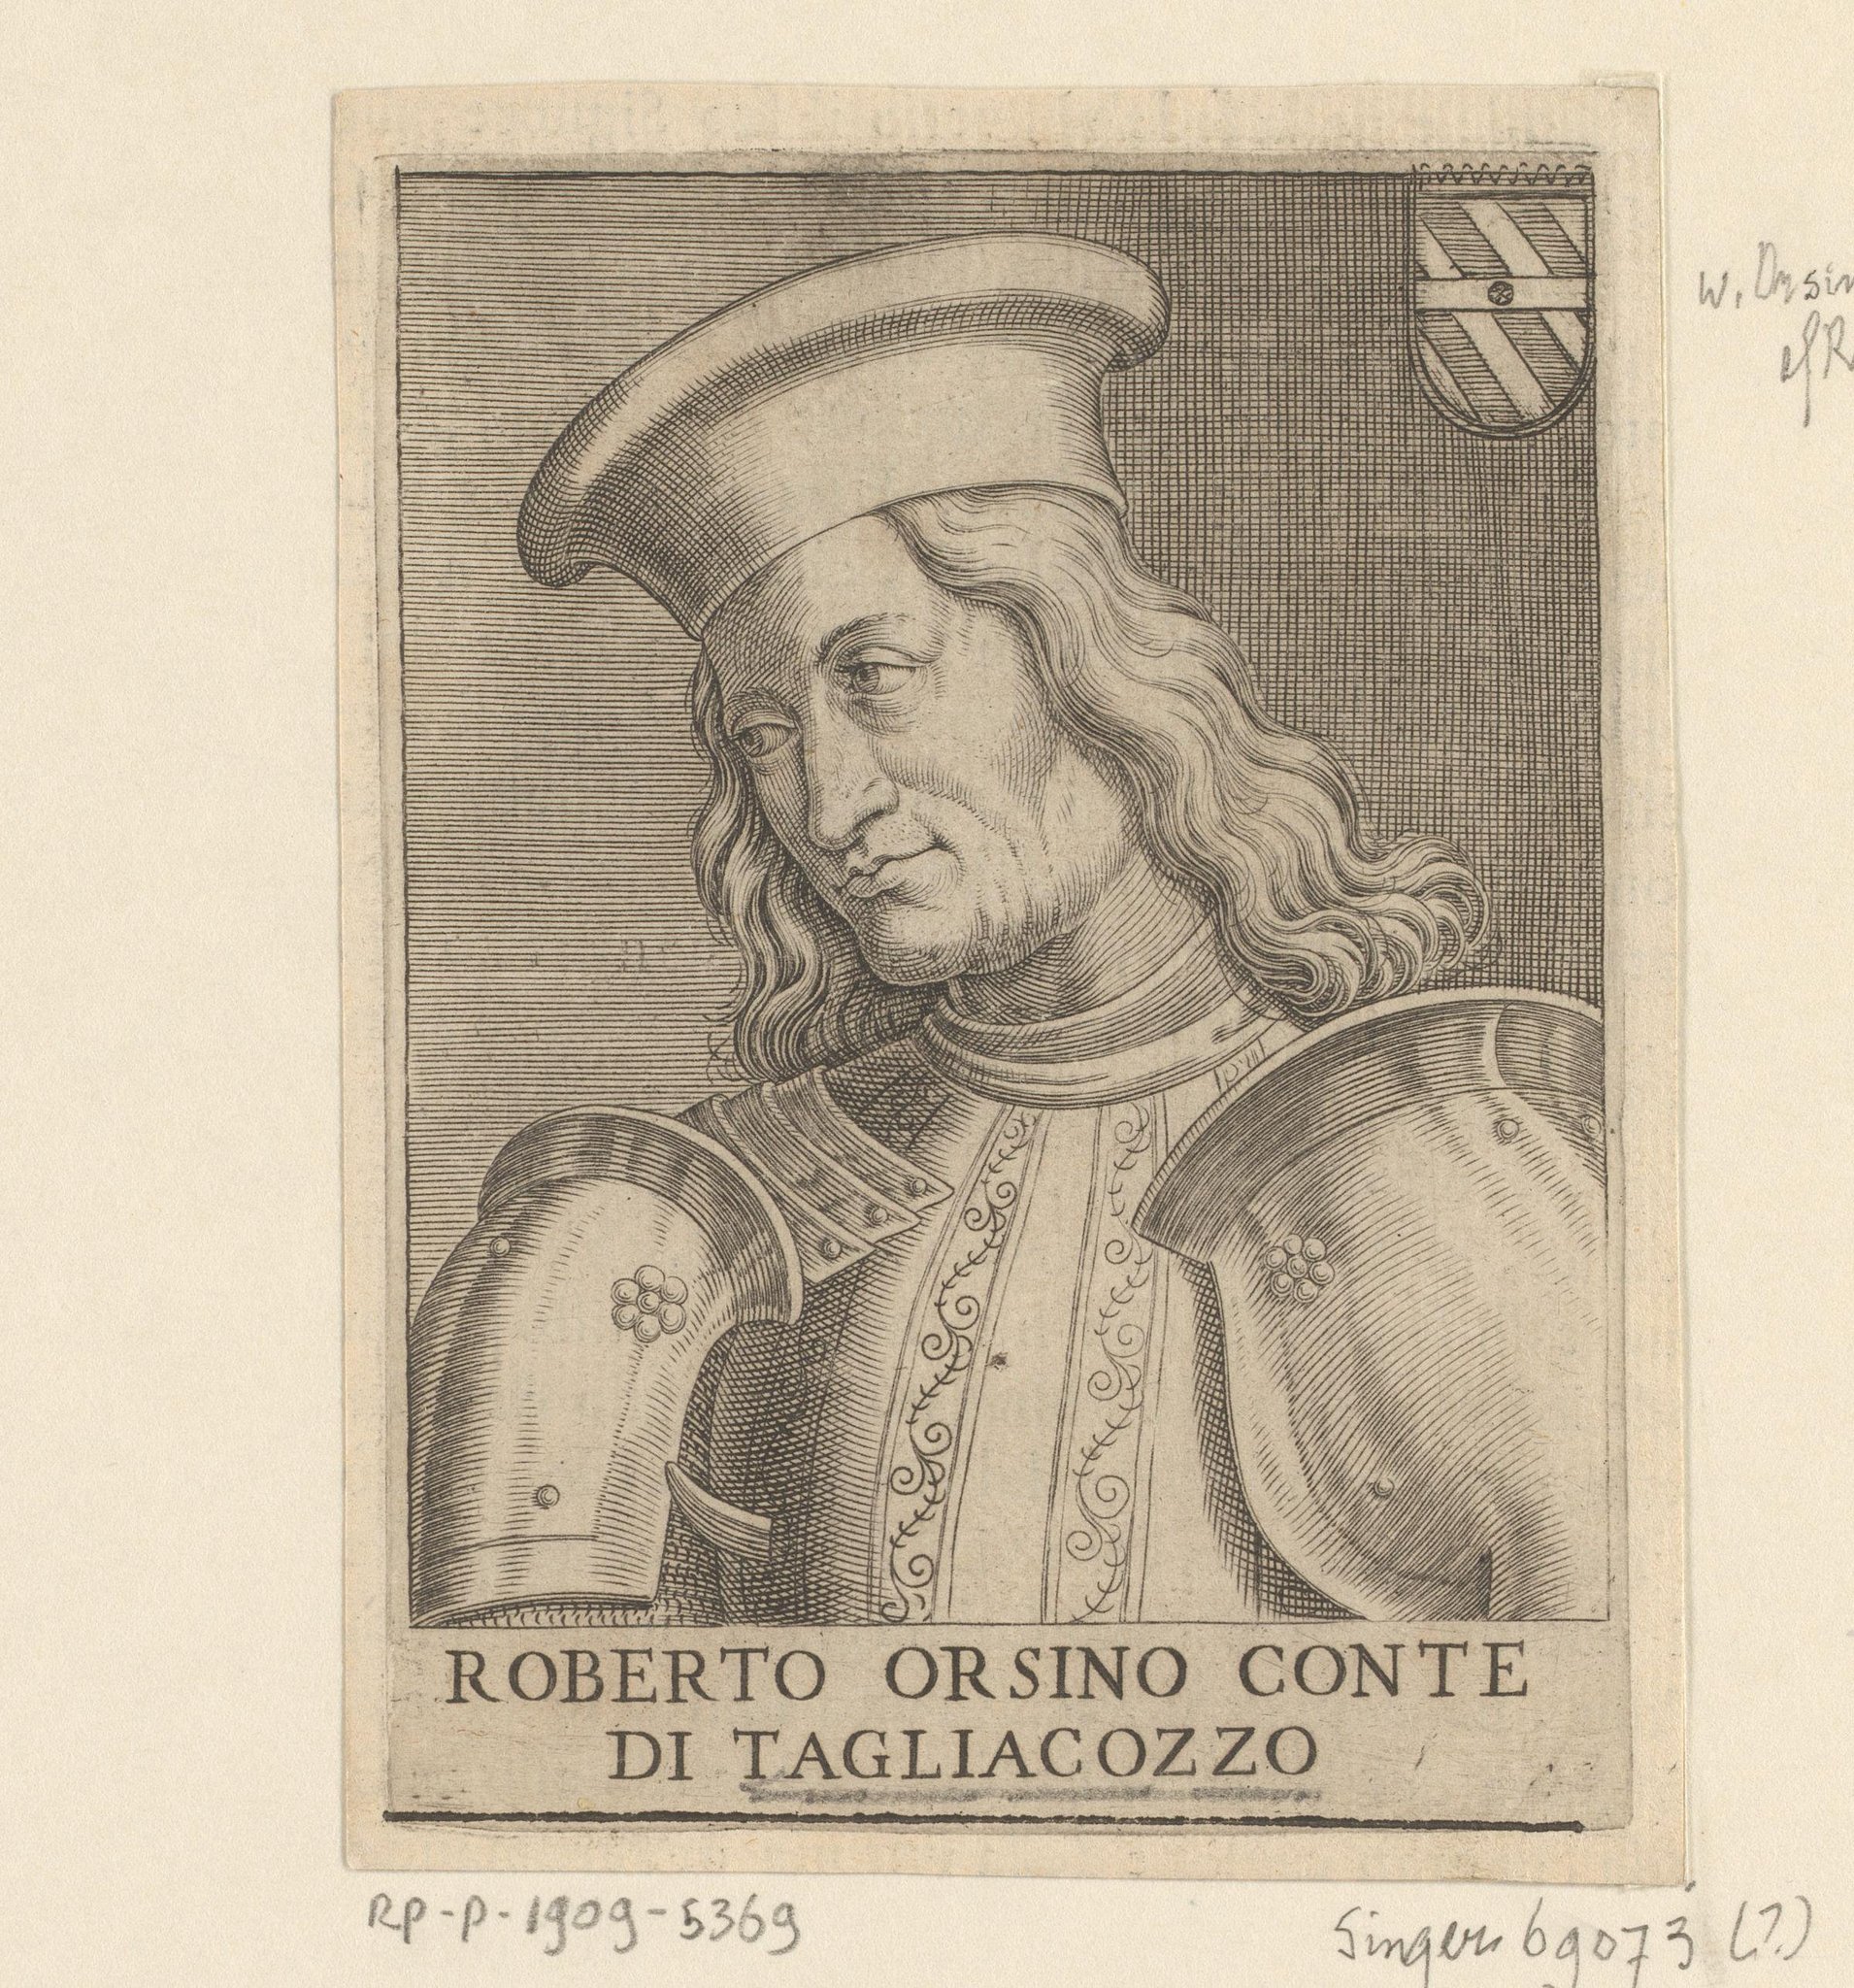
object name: print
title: Roberto Orsino conte di Tagliacozzo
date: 1646-1647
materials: paper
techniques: engraving, letterpress printing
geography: rome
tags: earl, historical persons, ranks in the navy, armorial bearing, heraldry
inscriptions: collector's mark: Lugt 2228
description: Prent uit: Ritratti et elogii di capitani Illustri. Che ne'secoli moderni hanno gloriosamente guerreggiato. Rome: Filippo de'Rossi en Vitale Mascardi, 1646, p. 125. Prent ook gebruikt in dezelfde editie van 1647. Eerdere staat van prent in ieder geval ook gebruikt in: Ritratti et elogii di capitani Illustri. Rome: Pompilio Totti en Andrea Fei, 1635.